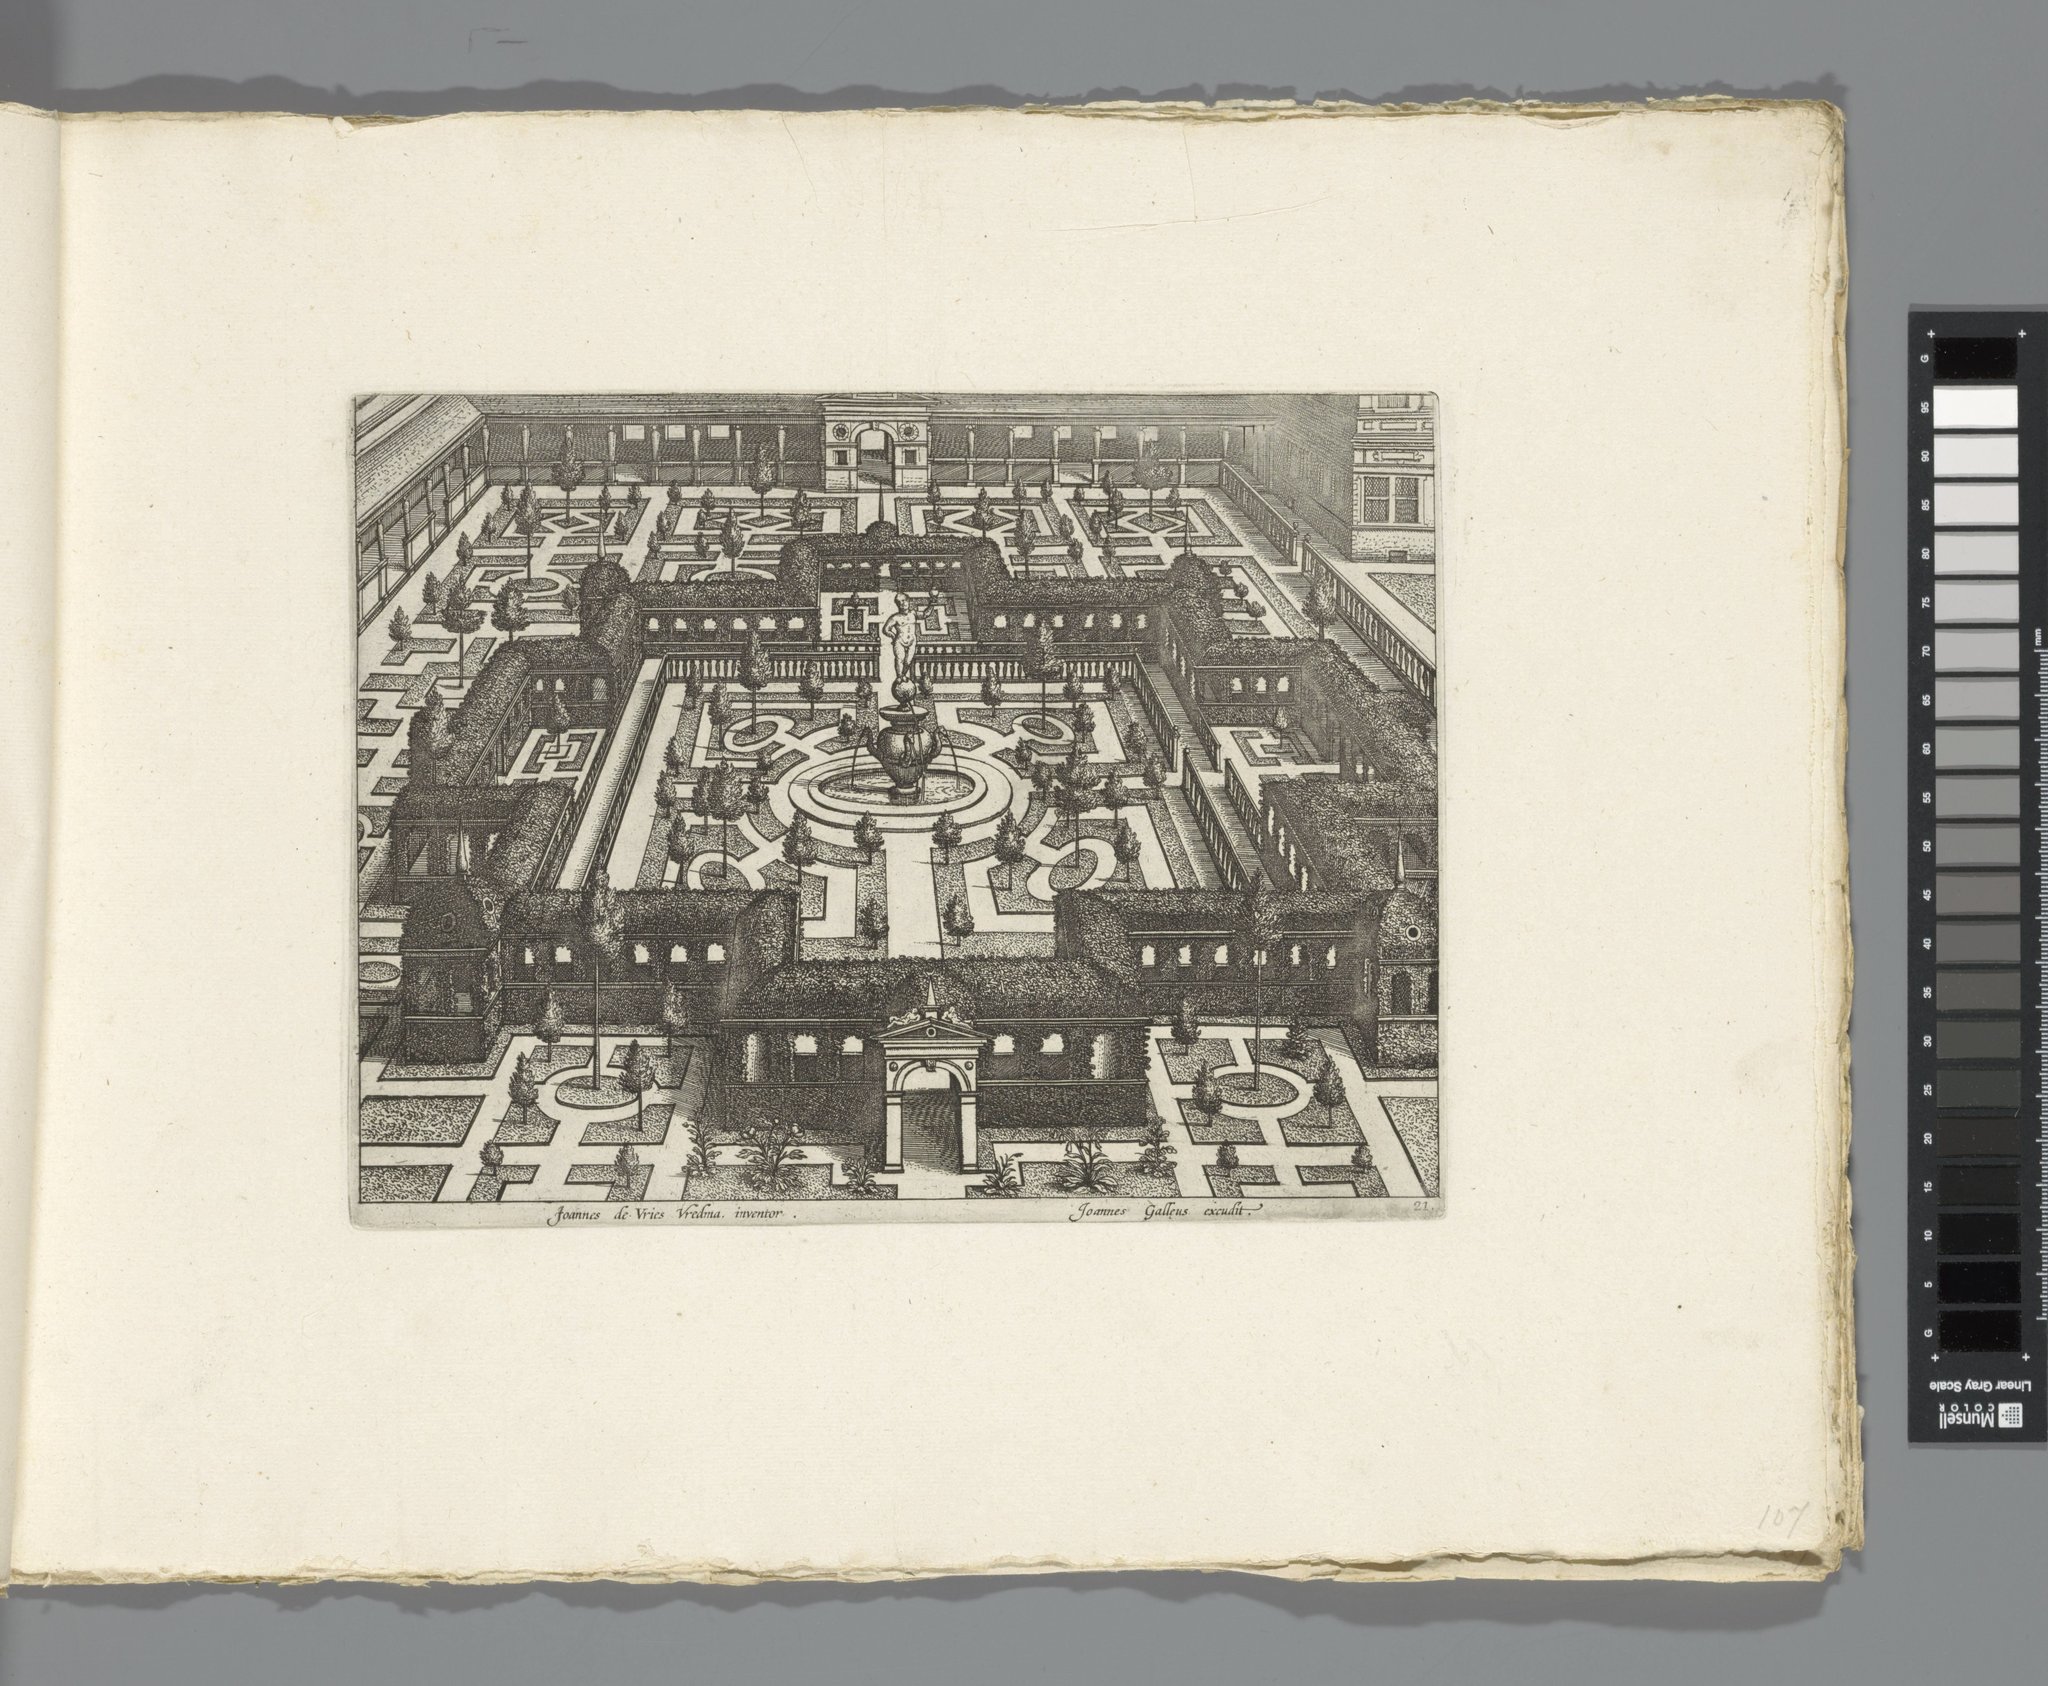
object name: print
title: Tuin met parterre met in het centrum een fontein met standbeeld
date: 1587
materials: paper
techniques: etching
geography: antwerp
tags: garden, french or architectonic garden; formal garden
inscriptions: collector's mark: Lugt 2228, collector's mark: Lugt 2760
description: De serie ‘Hortorum Viridariorumque’ van Vredeman de Vries (Hollstein Dutch 470-490) is in deze editie van de serie door uitgever Joannes Galle ( en eerder door zijn voorganger Theodoor Galle) aangevuld met de serie ‘Tuinen’ van Vredeman de Vries (Hollstein Dutch 508-515) en met twee prenten van Pieter van der Borcht (I) (New Hollstein Dutch 161-162). De prenten zijn genummerd: 1-30. Origineel hoort bij deze editie van de serie, uitgegeven door Joannes Galle, nog een prent van Van der Borcht met nummer 31, maar deze prent ontbreekt in deze serie in de collectie van het Rijksmuseum.